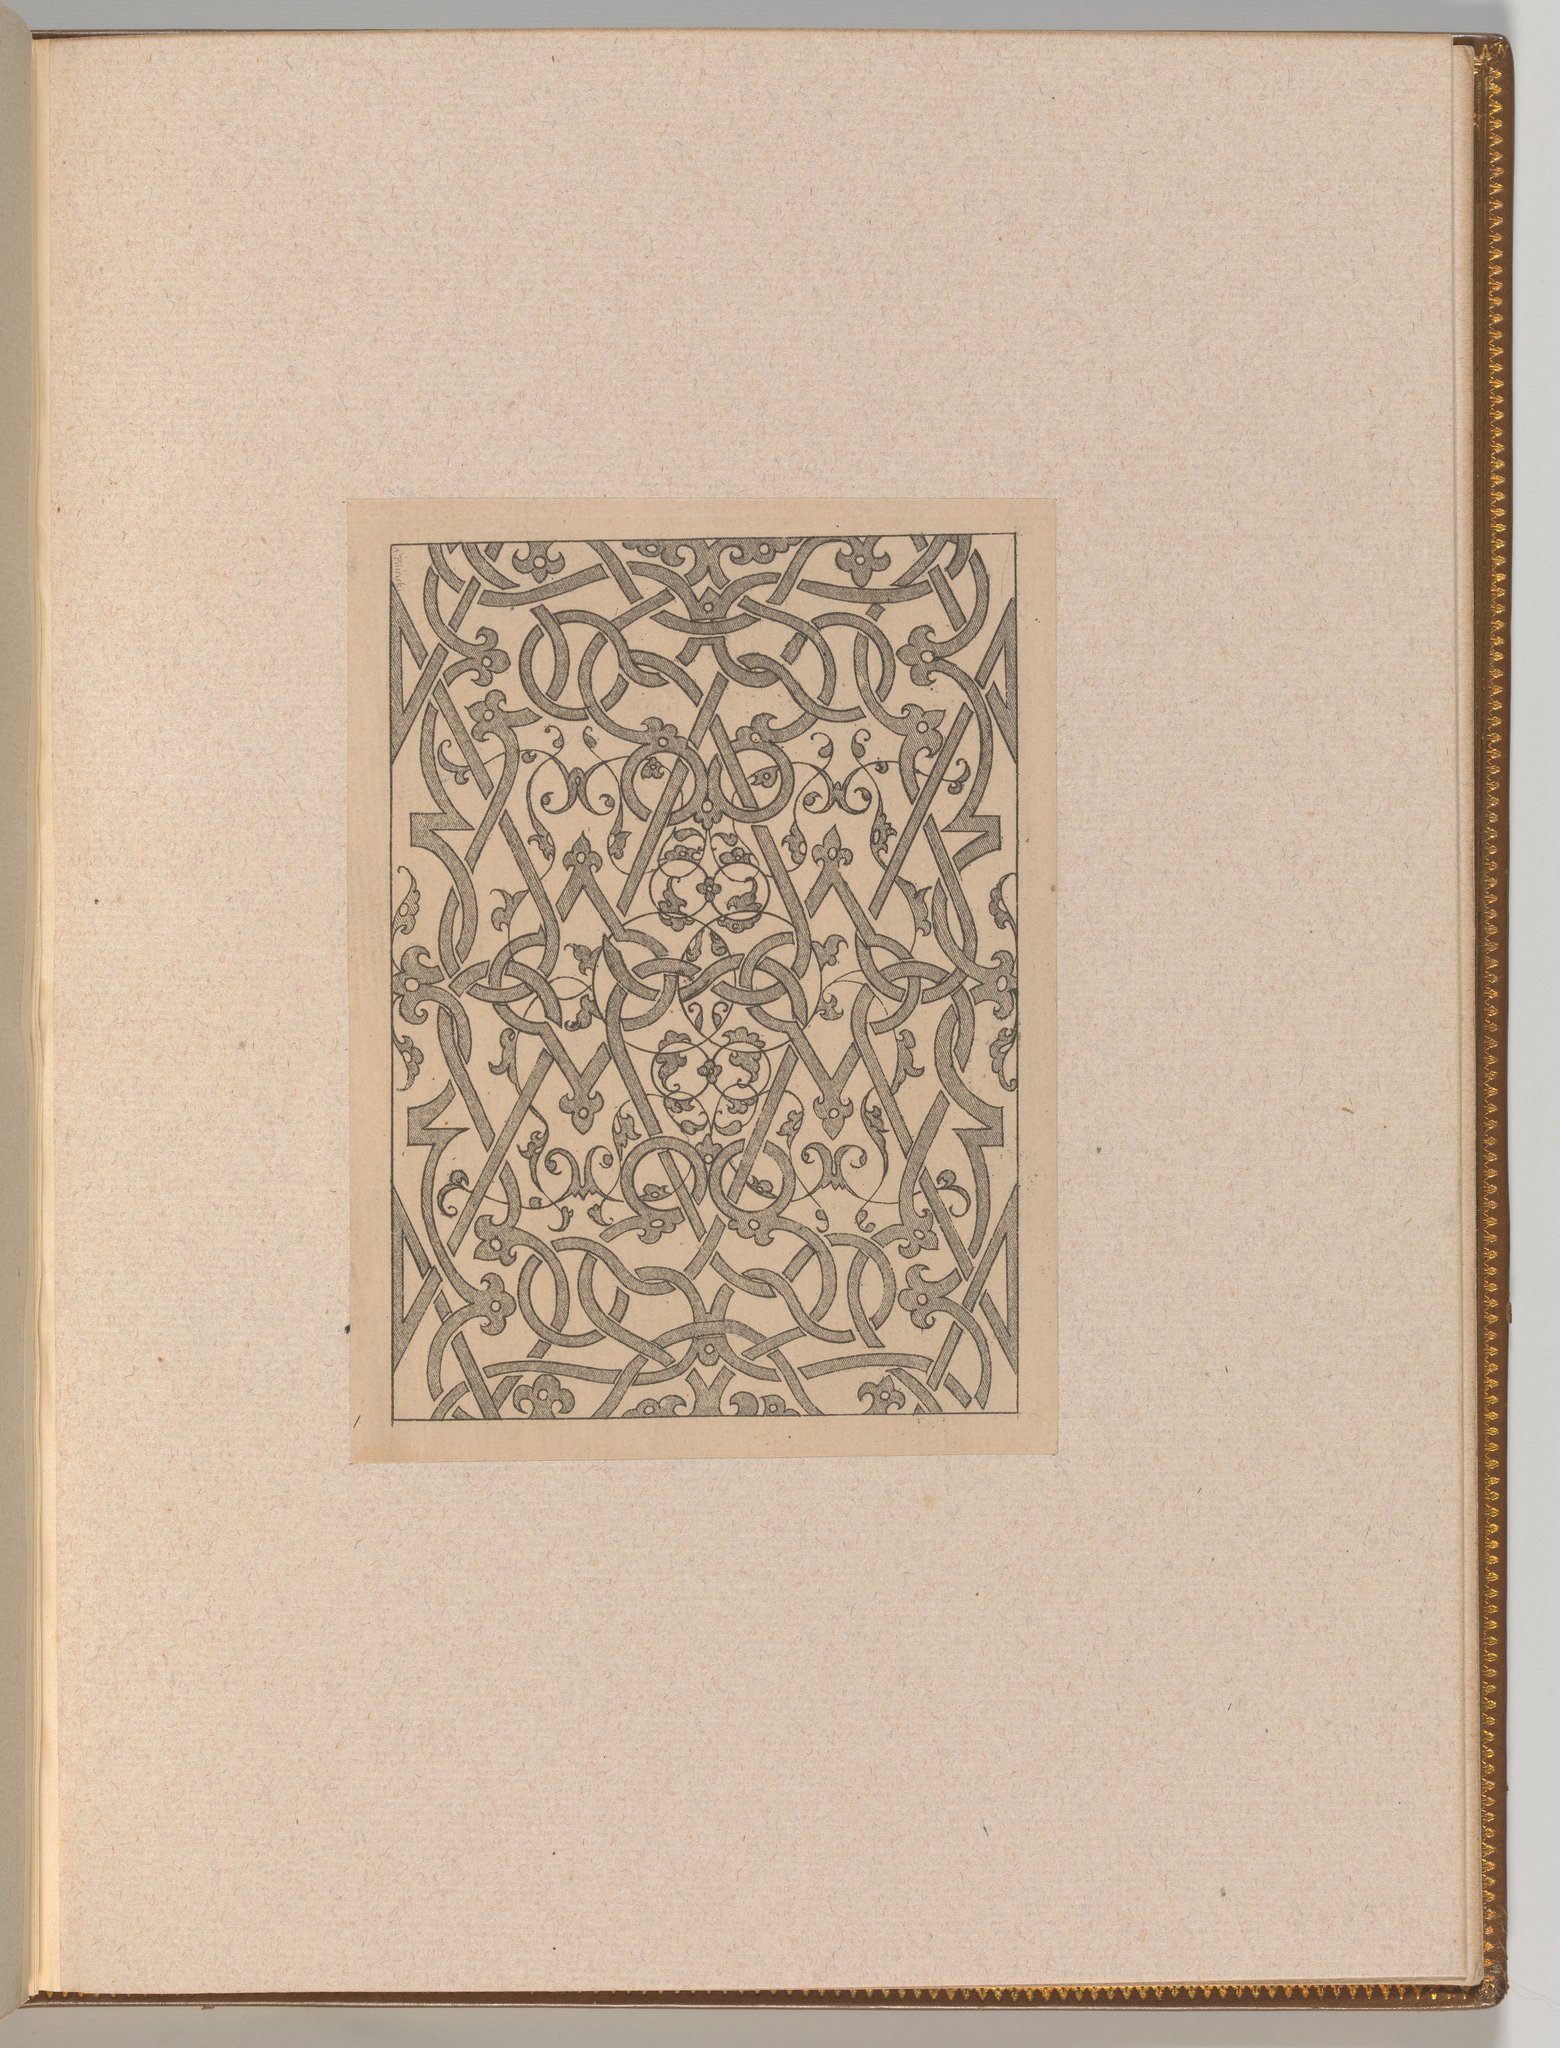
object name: album print ornament architecture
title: Copies after the 'Livre contenant passement de moresques' (plate 17)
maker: jacques androuet du cerceau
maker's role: artist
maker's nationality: french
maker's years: 1510-1585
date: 1801-1900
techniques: etching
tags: ornament